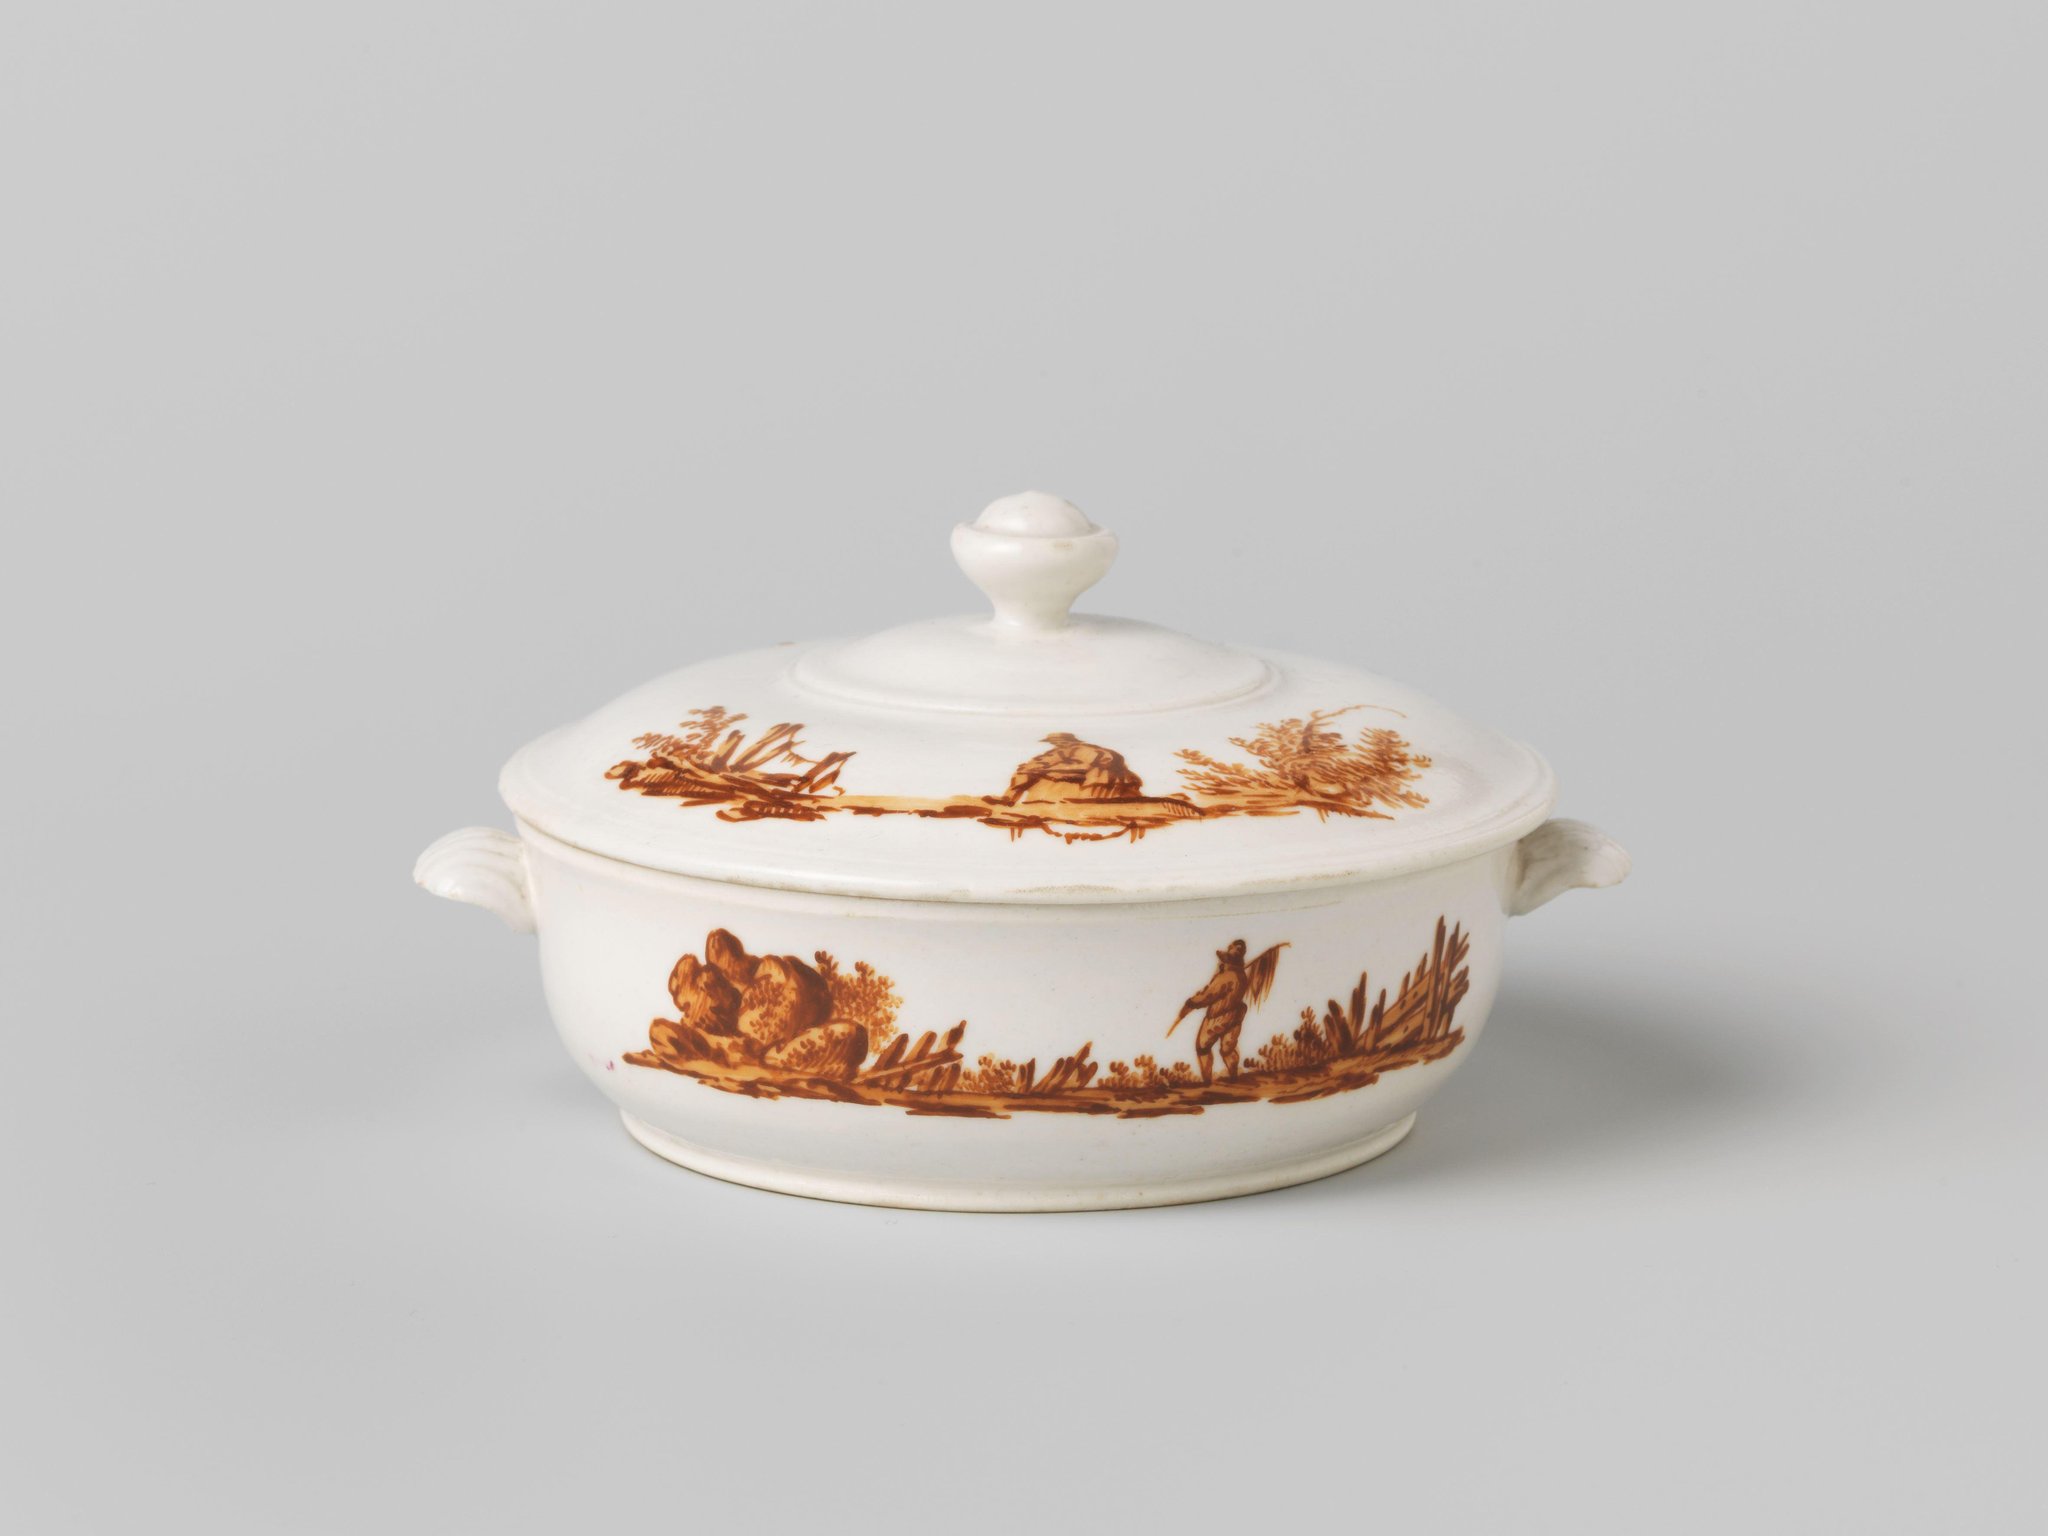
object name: lid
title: Deksel van botervloot, beschilderd met landschappen met figuren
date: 1774-1778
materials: porcelain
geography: loosdrecht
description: Deksel van porselein. Licht gewelfde gladde wand en deksel. Deksel met geprofileerde rand en iets verhoogd en geprofileerd middenstuk met knop. Aan beide zijden van de vloot en twee maal op de deksels een landschapsgrondje in sepia zonder, met één of met twee figuren.